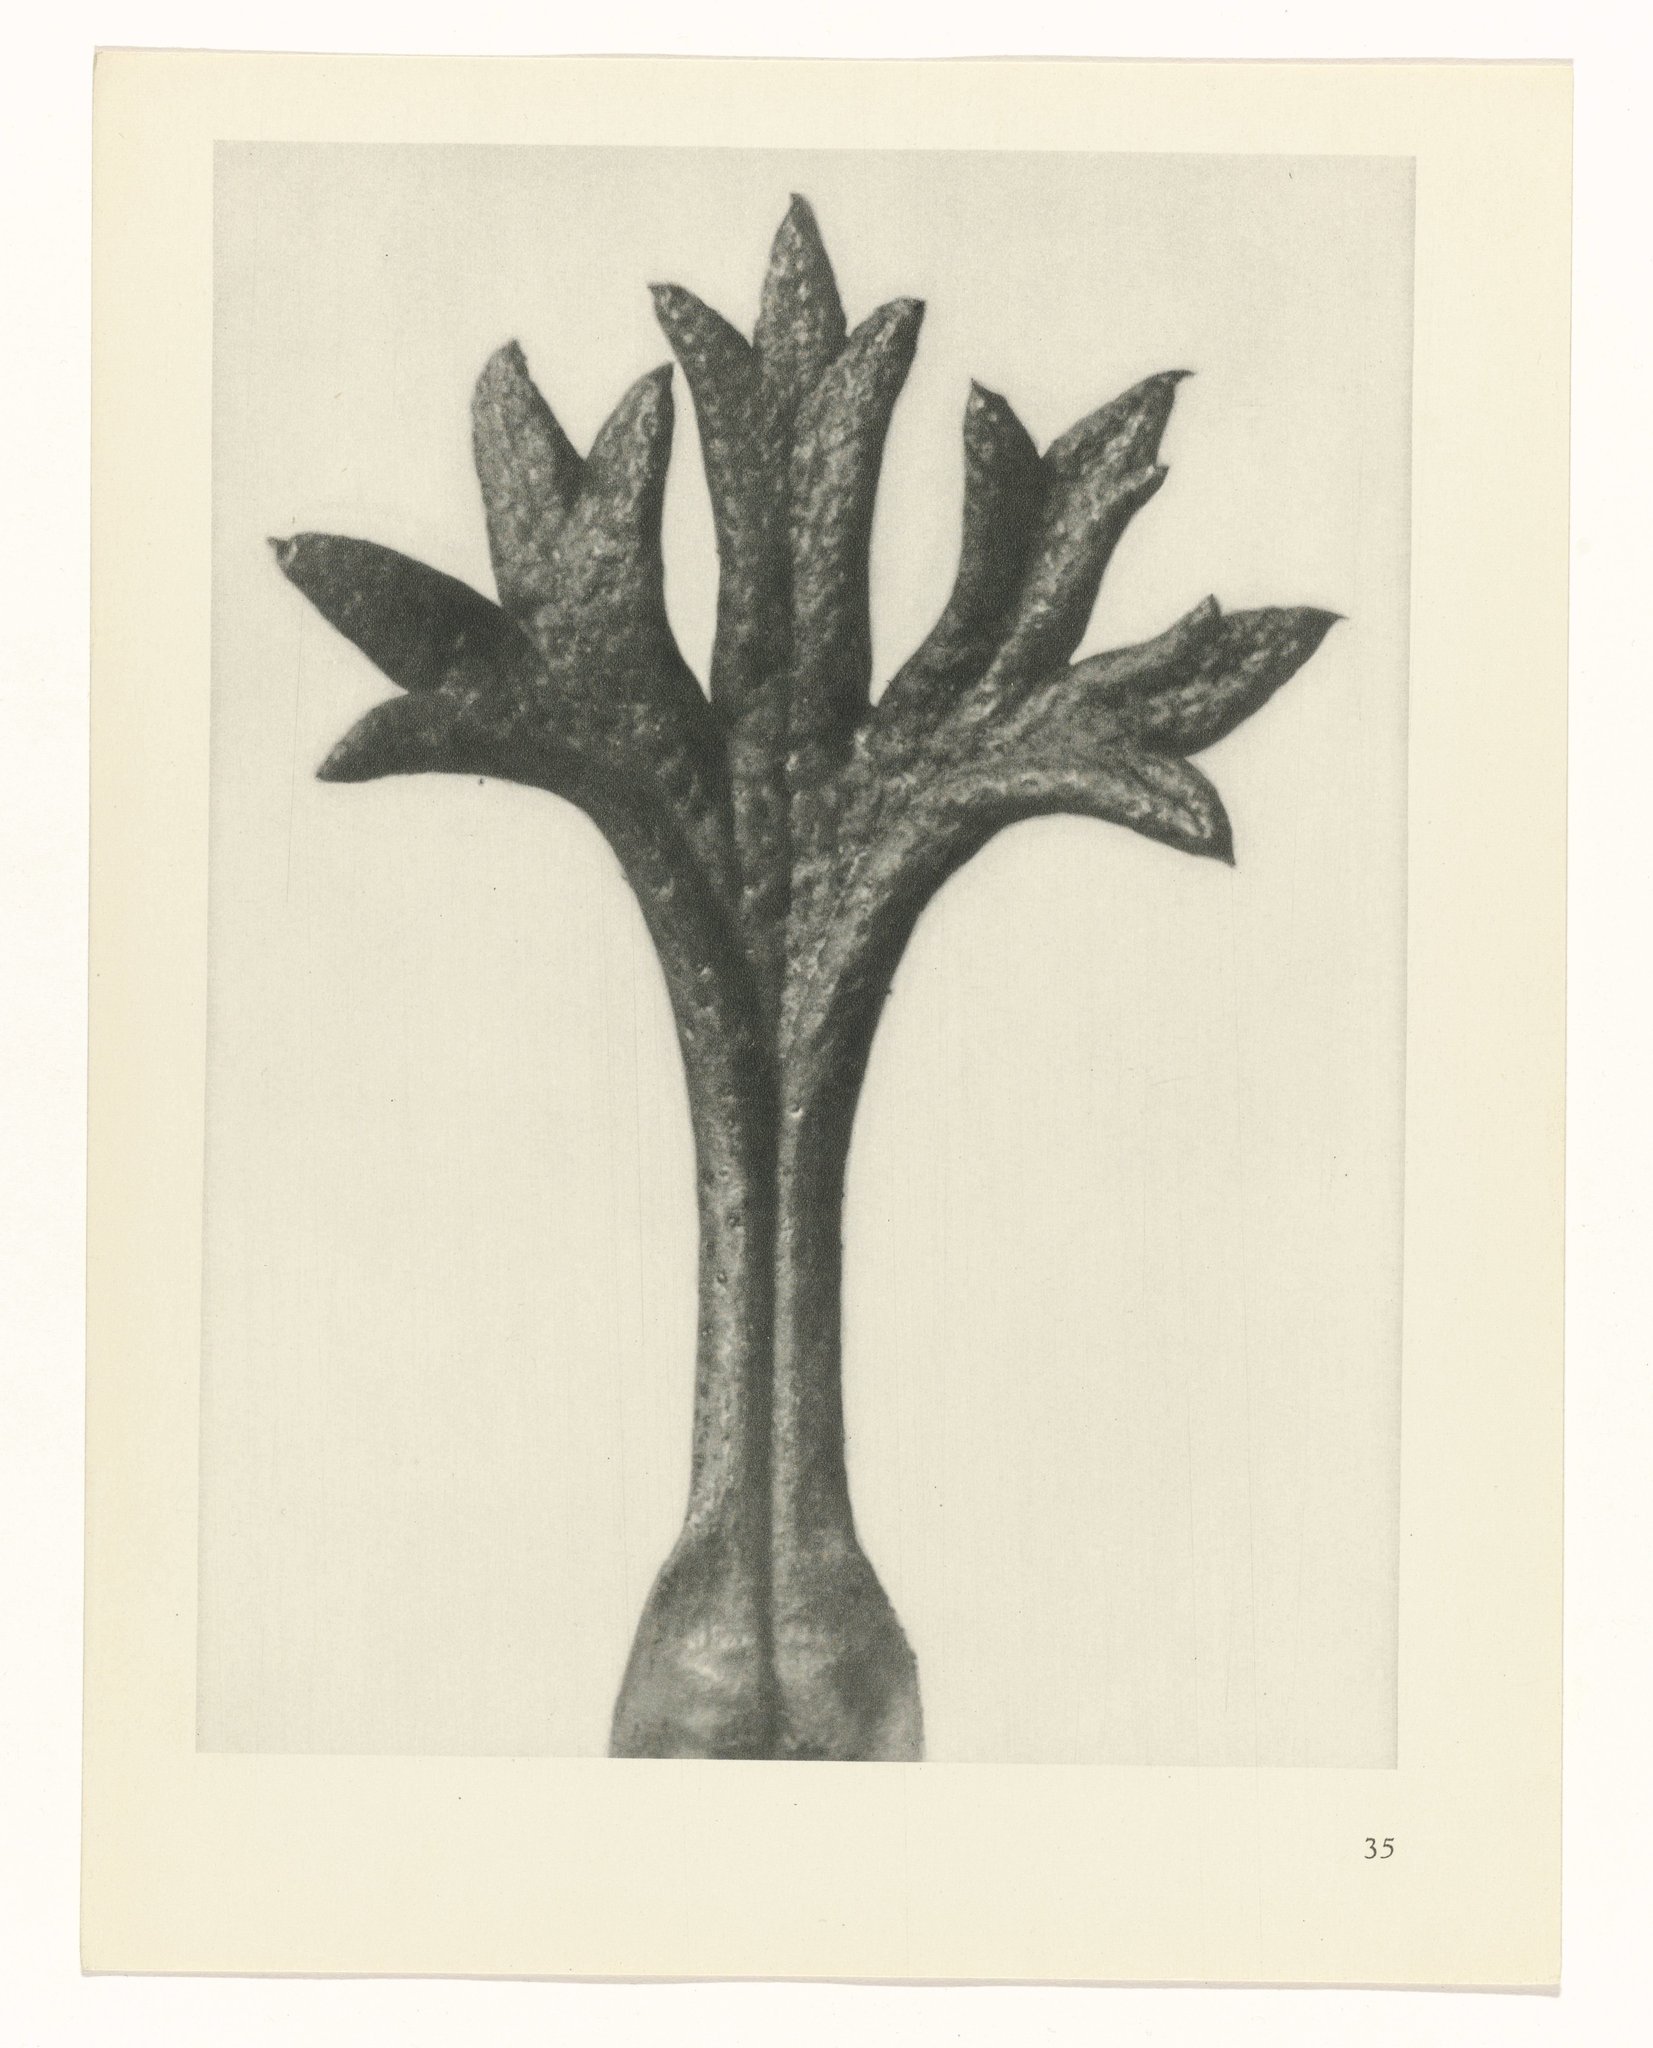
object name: photograph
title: Plantstudie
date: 1928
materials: ink, paper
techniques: rotogravure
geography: berlin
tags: plants (in general)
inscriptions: number: ‘35’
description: facher Vergrößerung. Afkomstig uit losbladige uitgave.